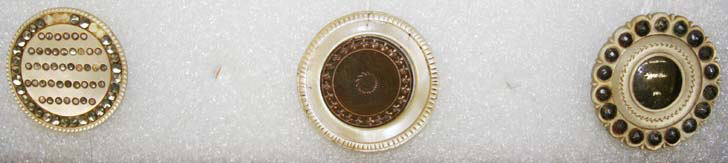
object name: button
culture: french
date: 1780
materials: metal, mother of pearl, paste